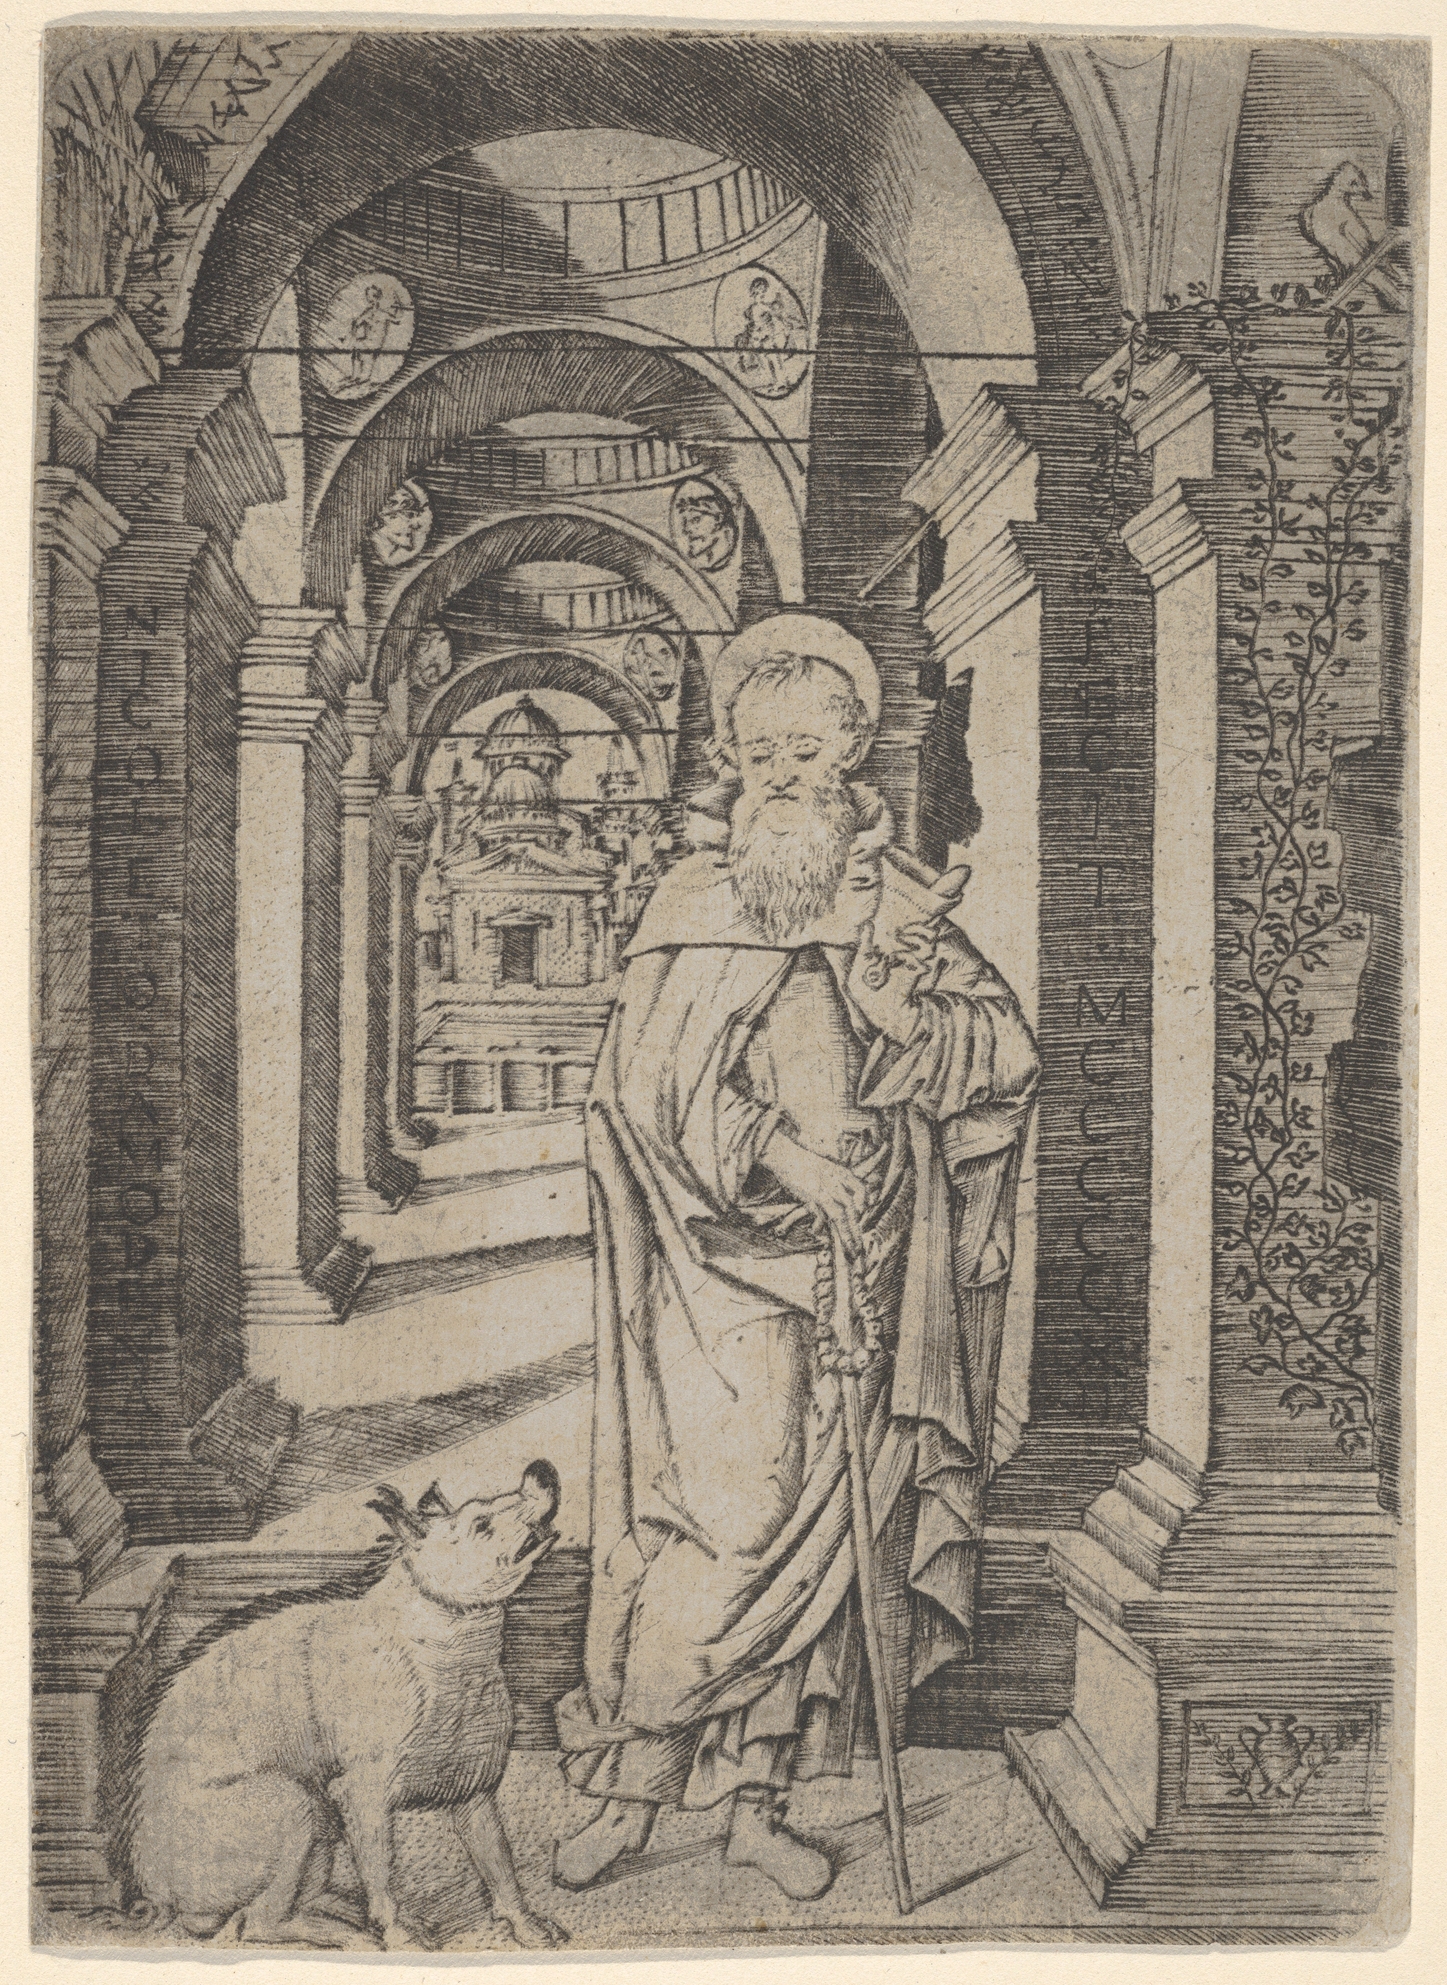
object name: print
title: Saint Antony Abbot standing within a colonnade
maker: nicoletto da modena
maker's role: artist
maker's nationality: italian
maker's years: 1500-1520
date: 1512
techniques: engraving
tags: birds,arches,dogs,leaves,saints